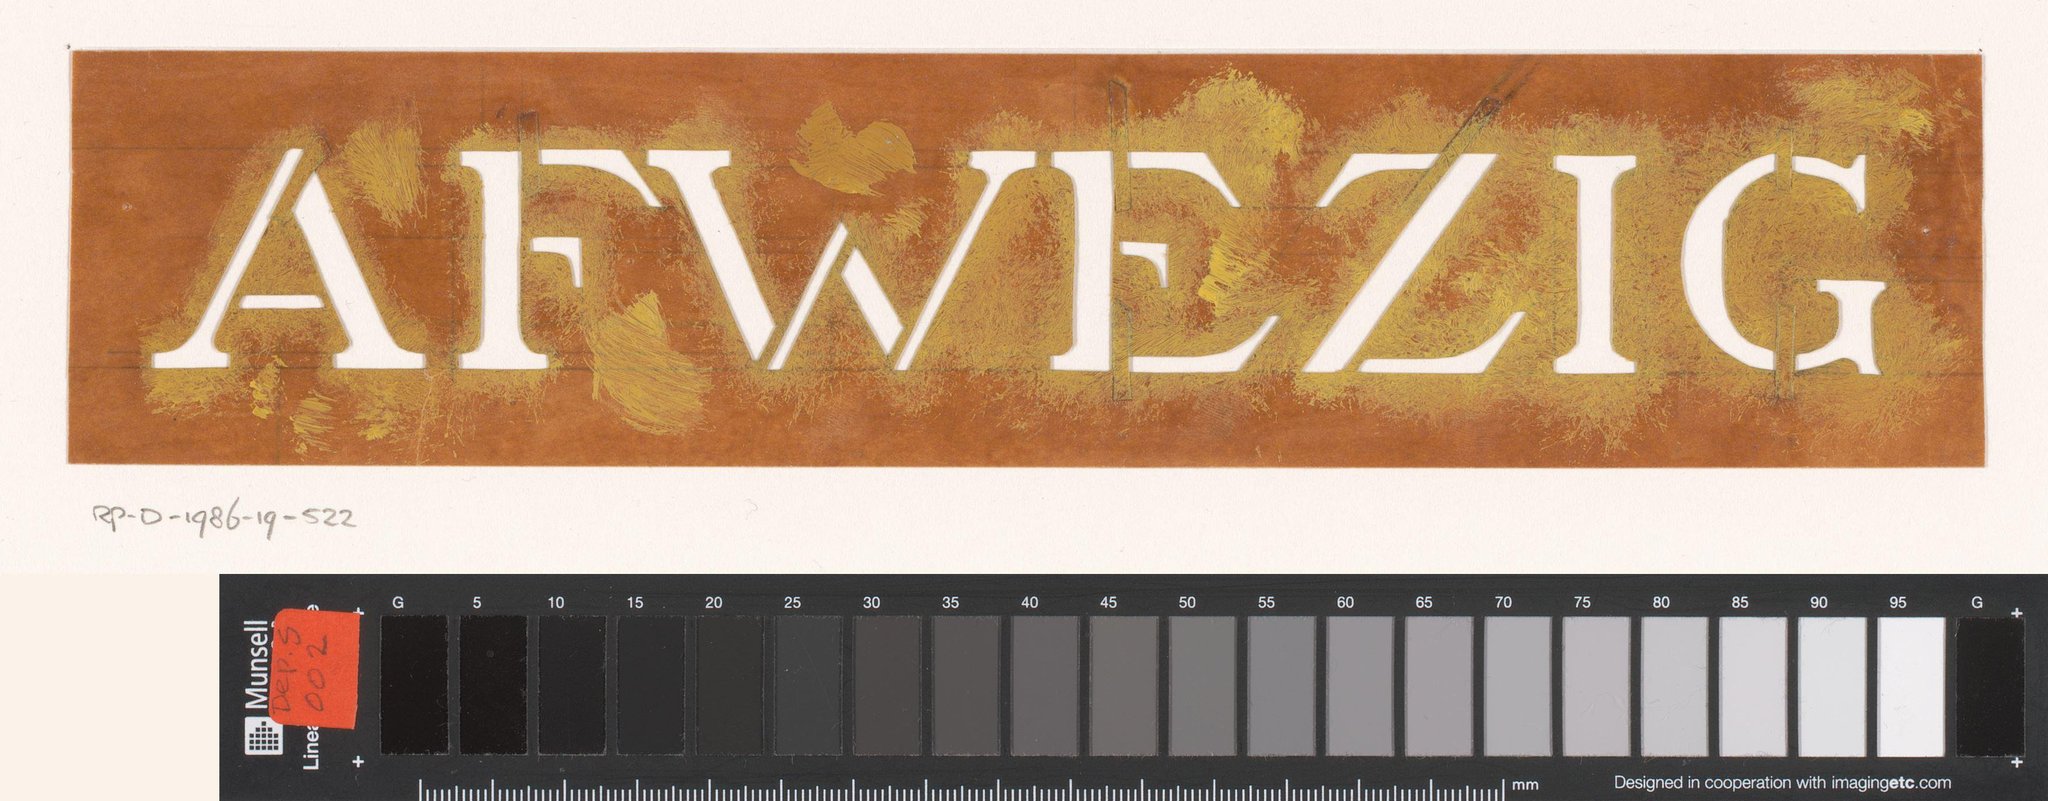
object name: template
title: Sjabloon met de tekst 'AFWEZIG'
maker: reinier willem petrus de vries (1874-1953)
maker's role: draughtsman, print maker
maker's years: 1874-1953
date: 1884-1952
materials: paper, pencil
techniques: cutting, snipping